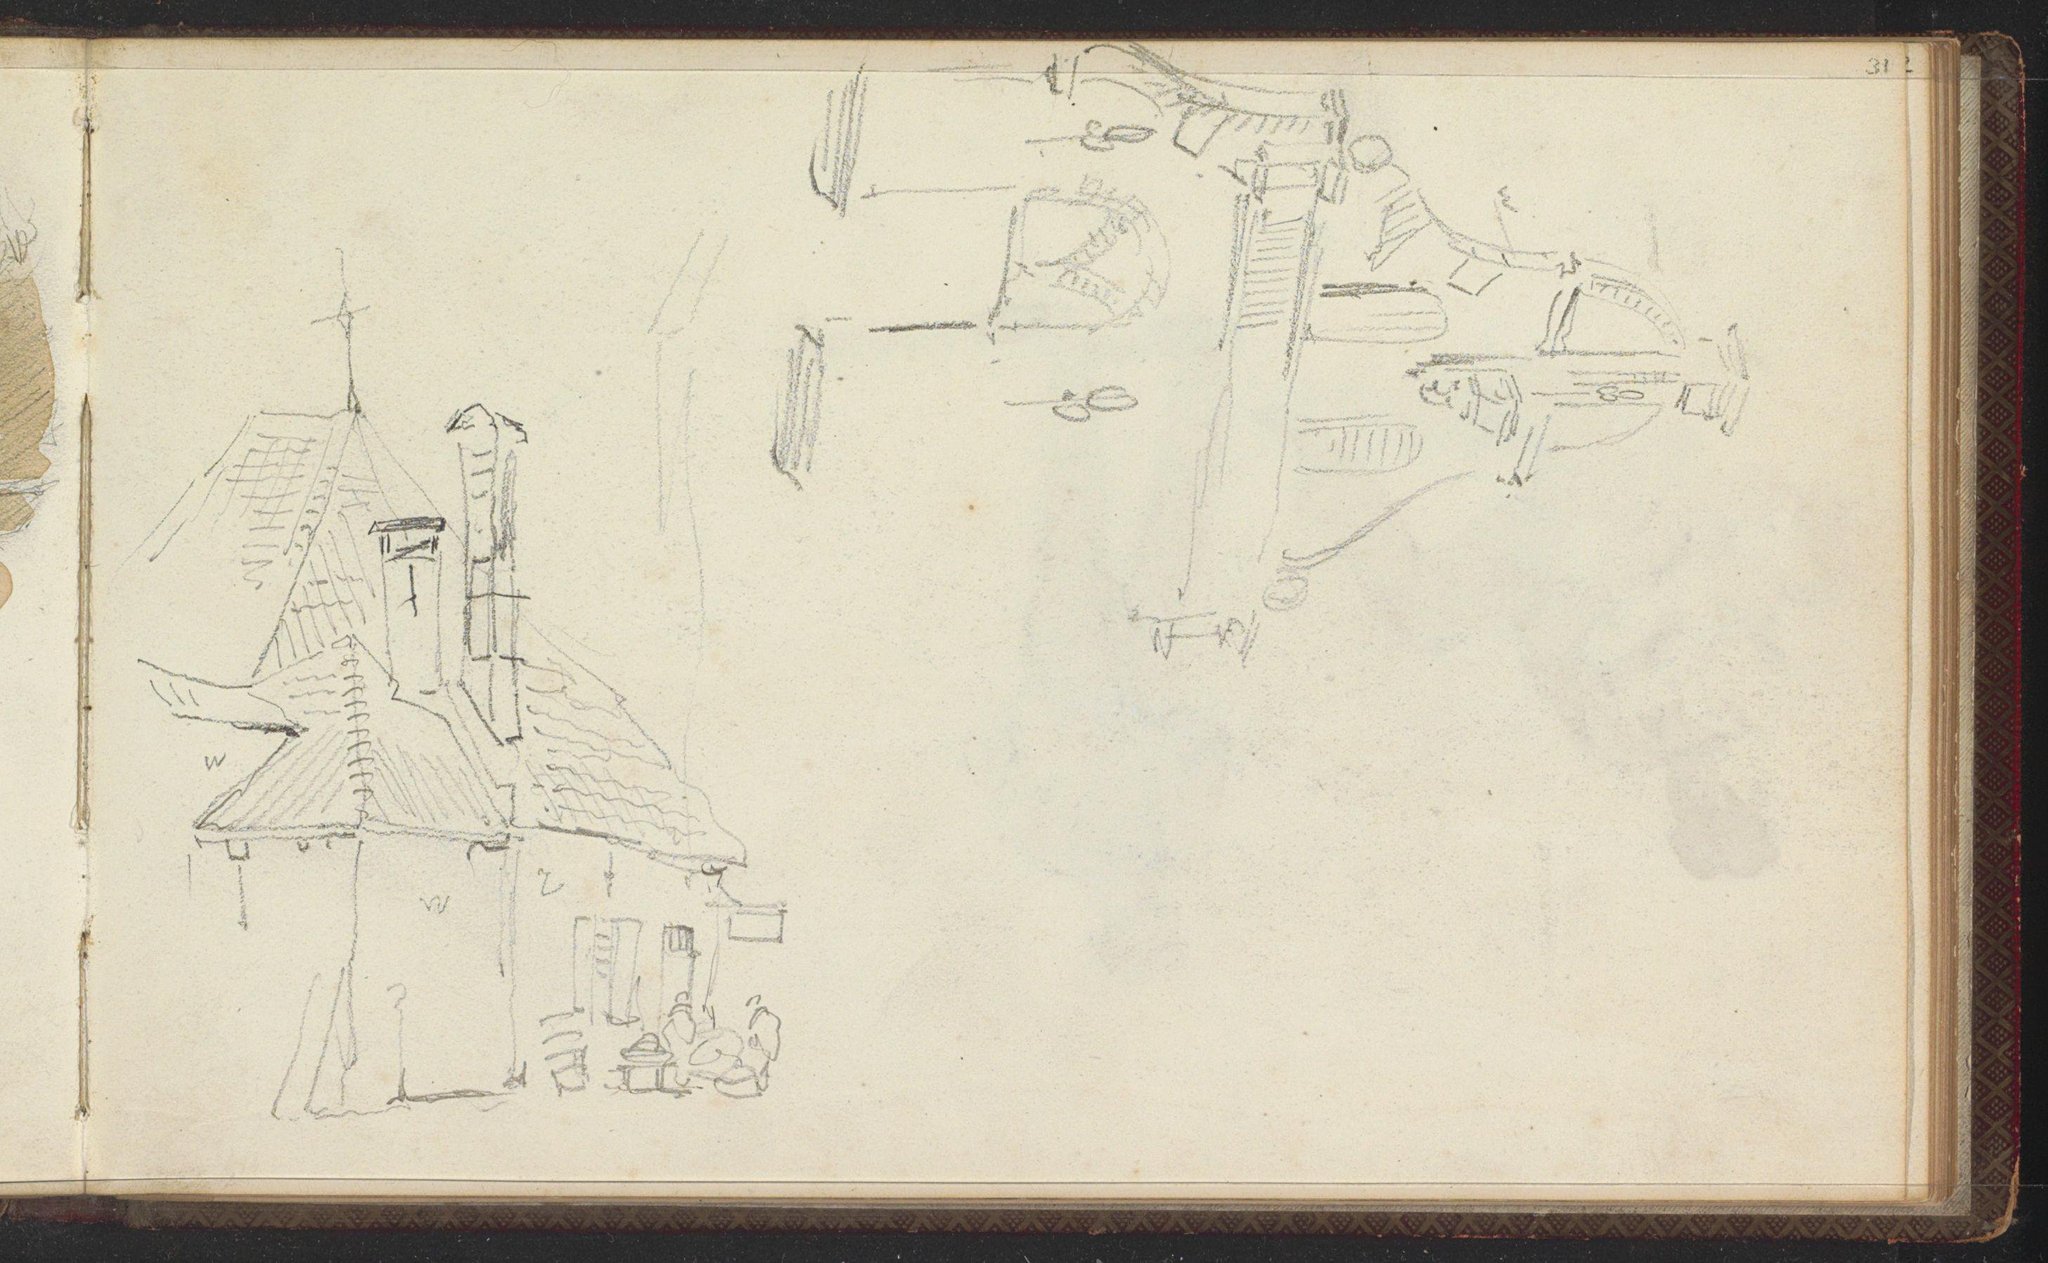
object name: sketchbook leaf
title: Twee gebouwen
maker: adrianus eversen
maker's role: draughtsman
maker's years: 1818-1897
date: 1828-1897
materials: paper, pencil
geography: netherlands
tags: urban housing, decorated gable, architecture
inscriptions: kleurnotitie, handgeschreven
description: Links zitten figuren voor een gebouw, mogelijk een herberg. Rechts een klokgevel. Blad 31 recto uit een schetsboek met 52 bladen vervaardigd in de omgeving van Kampen, Hattem, Hoorn en Zwolle.